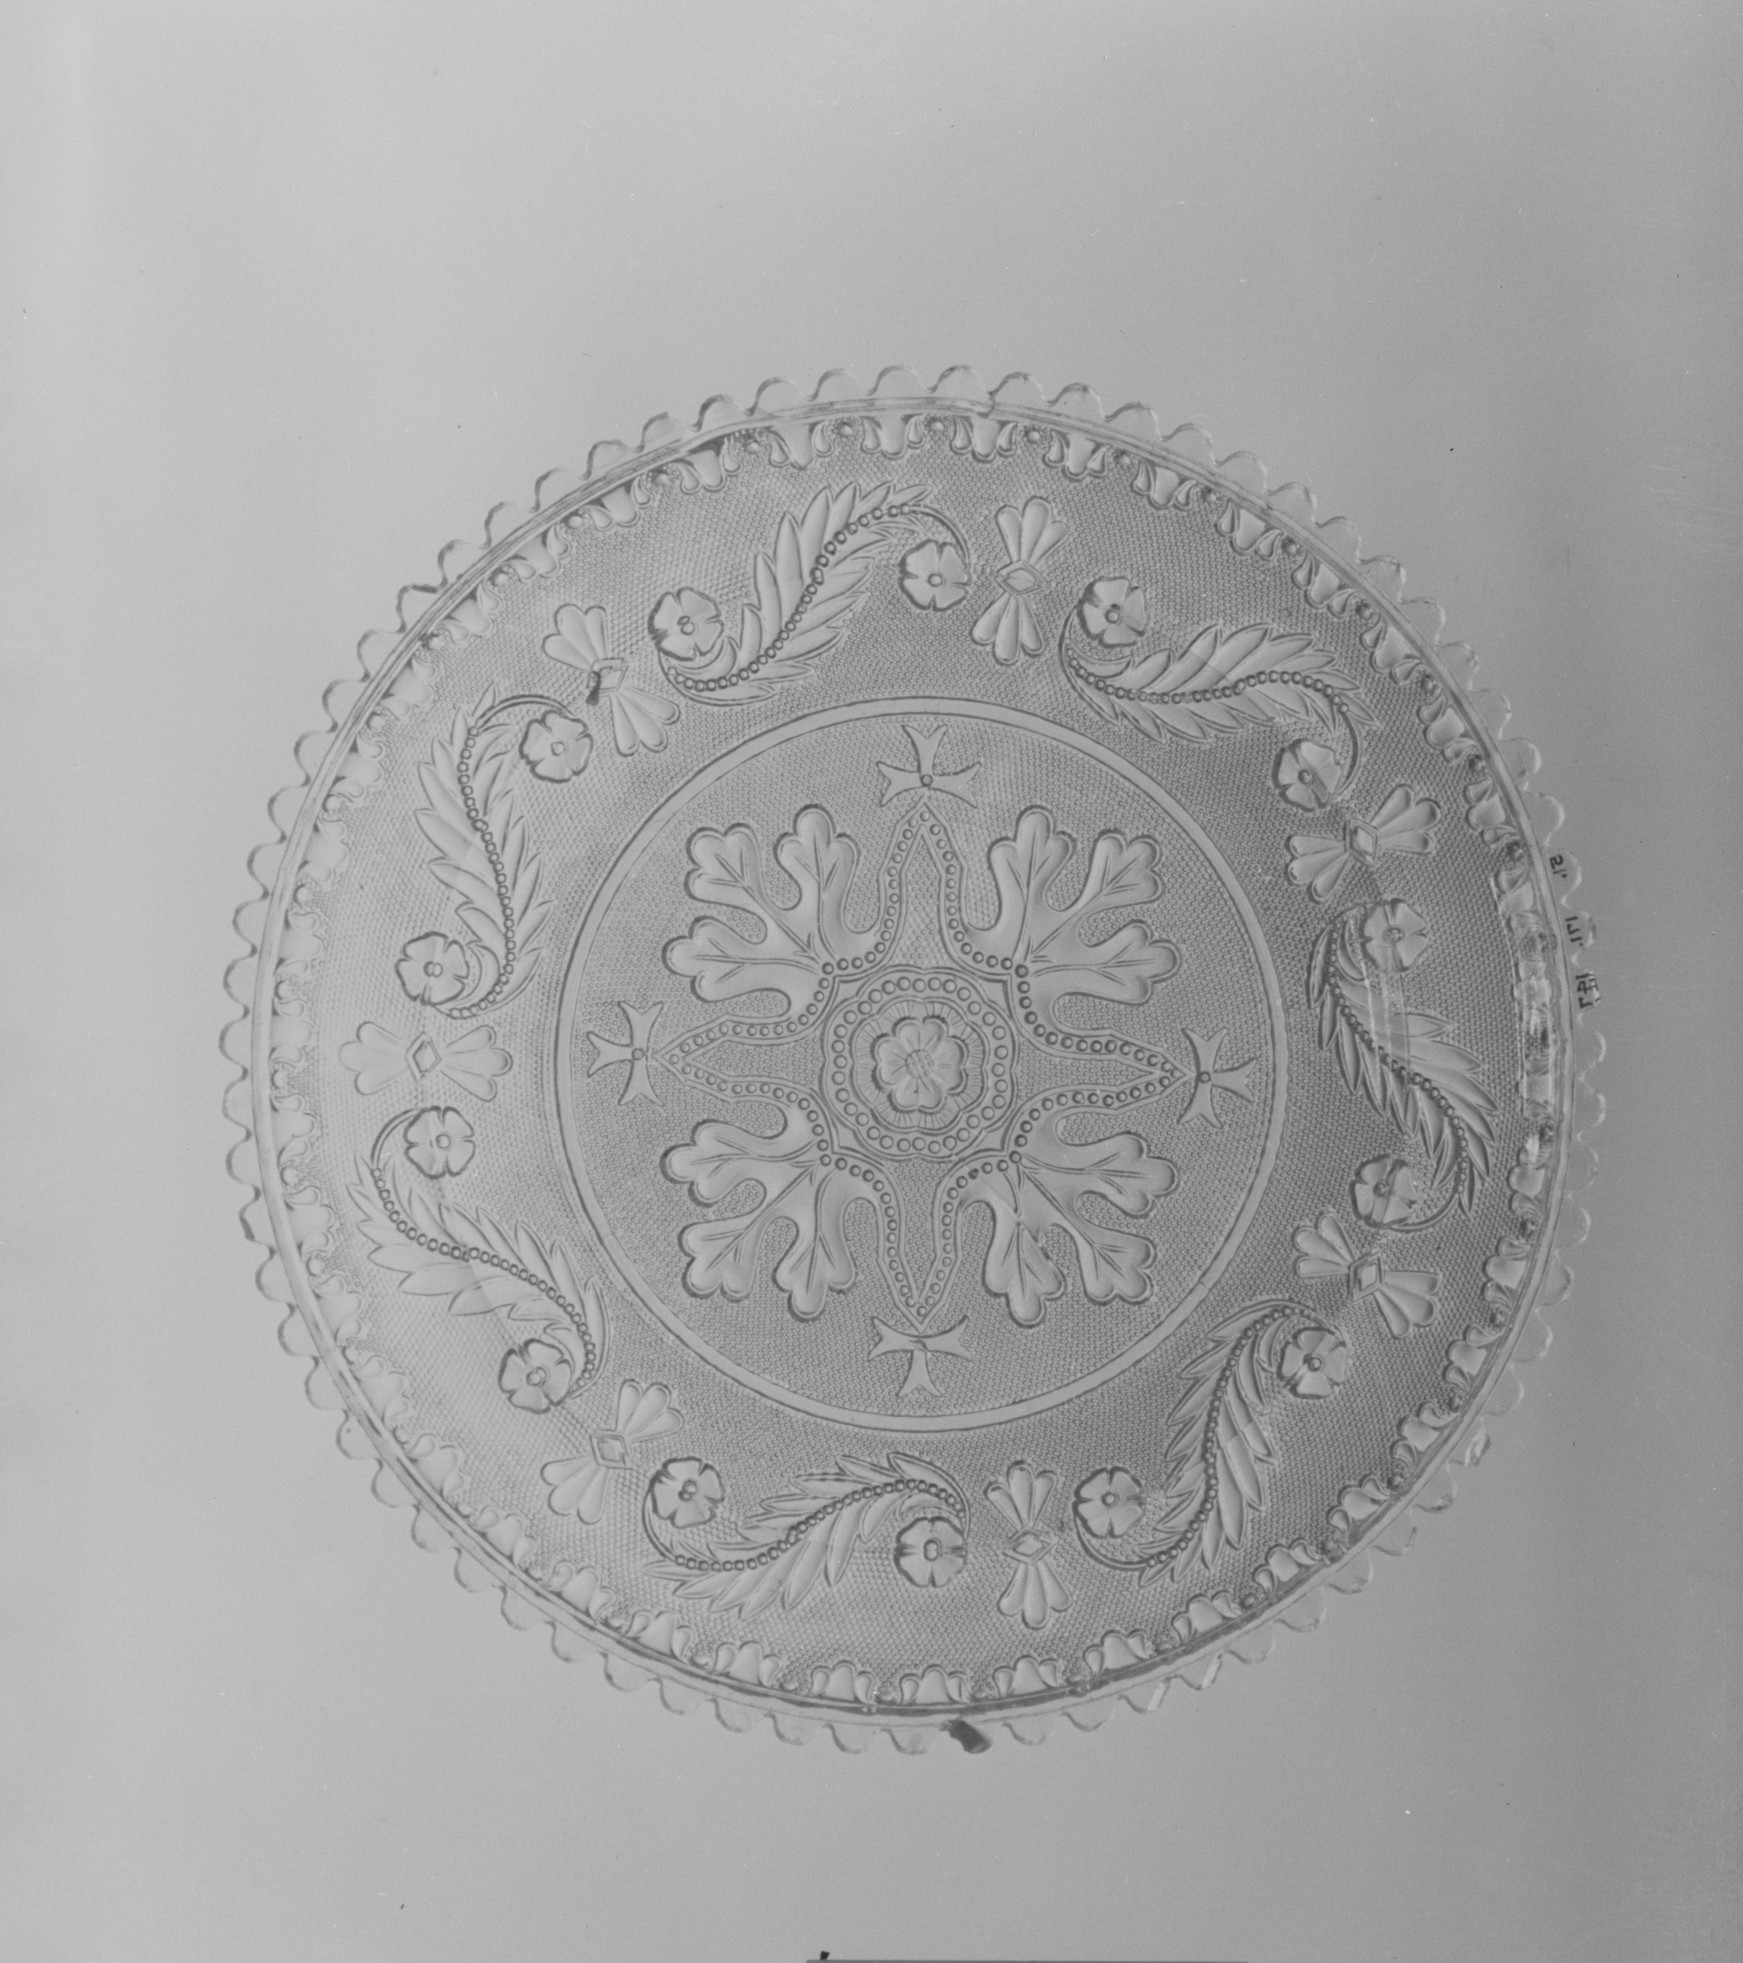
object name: plate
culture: american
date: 1830-1845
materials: glass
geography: united states